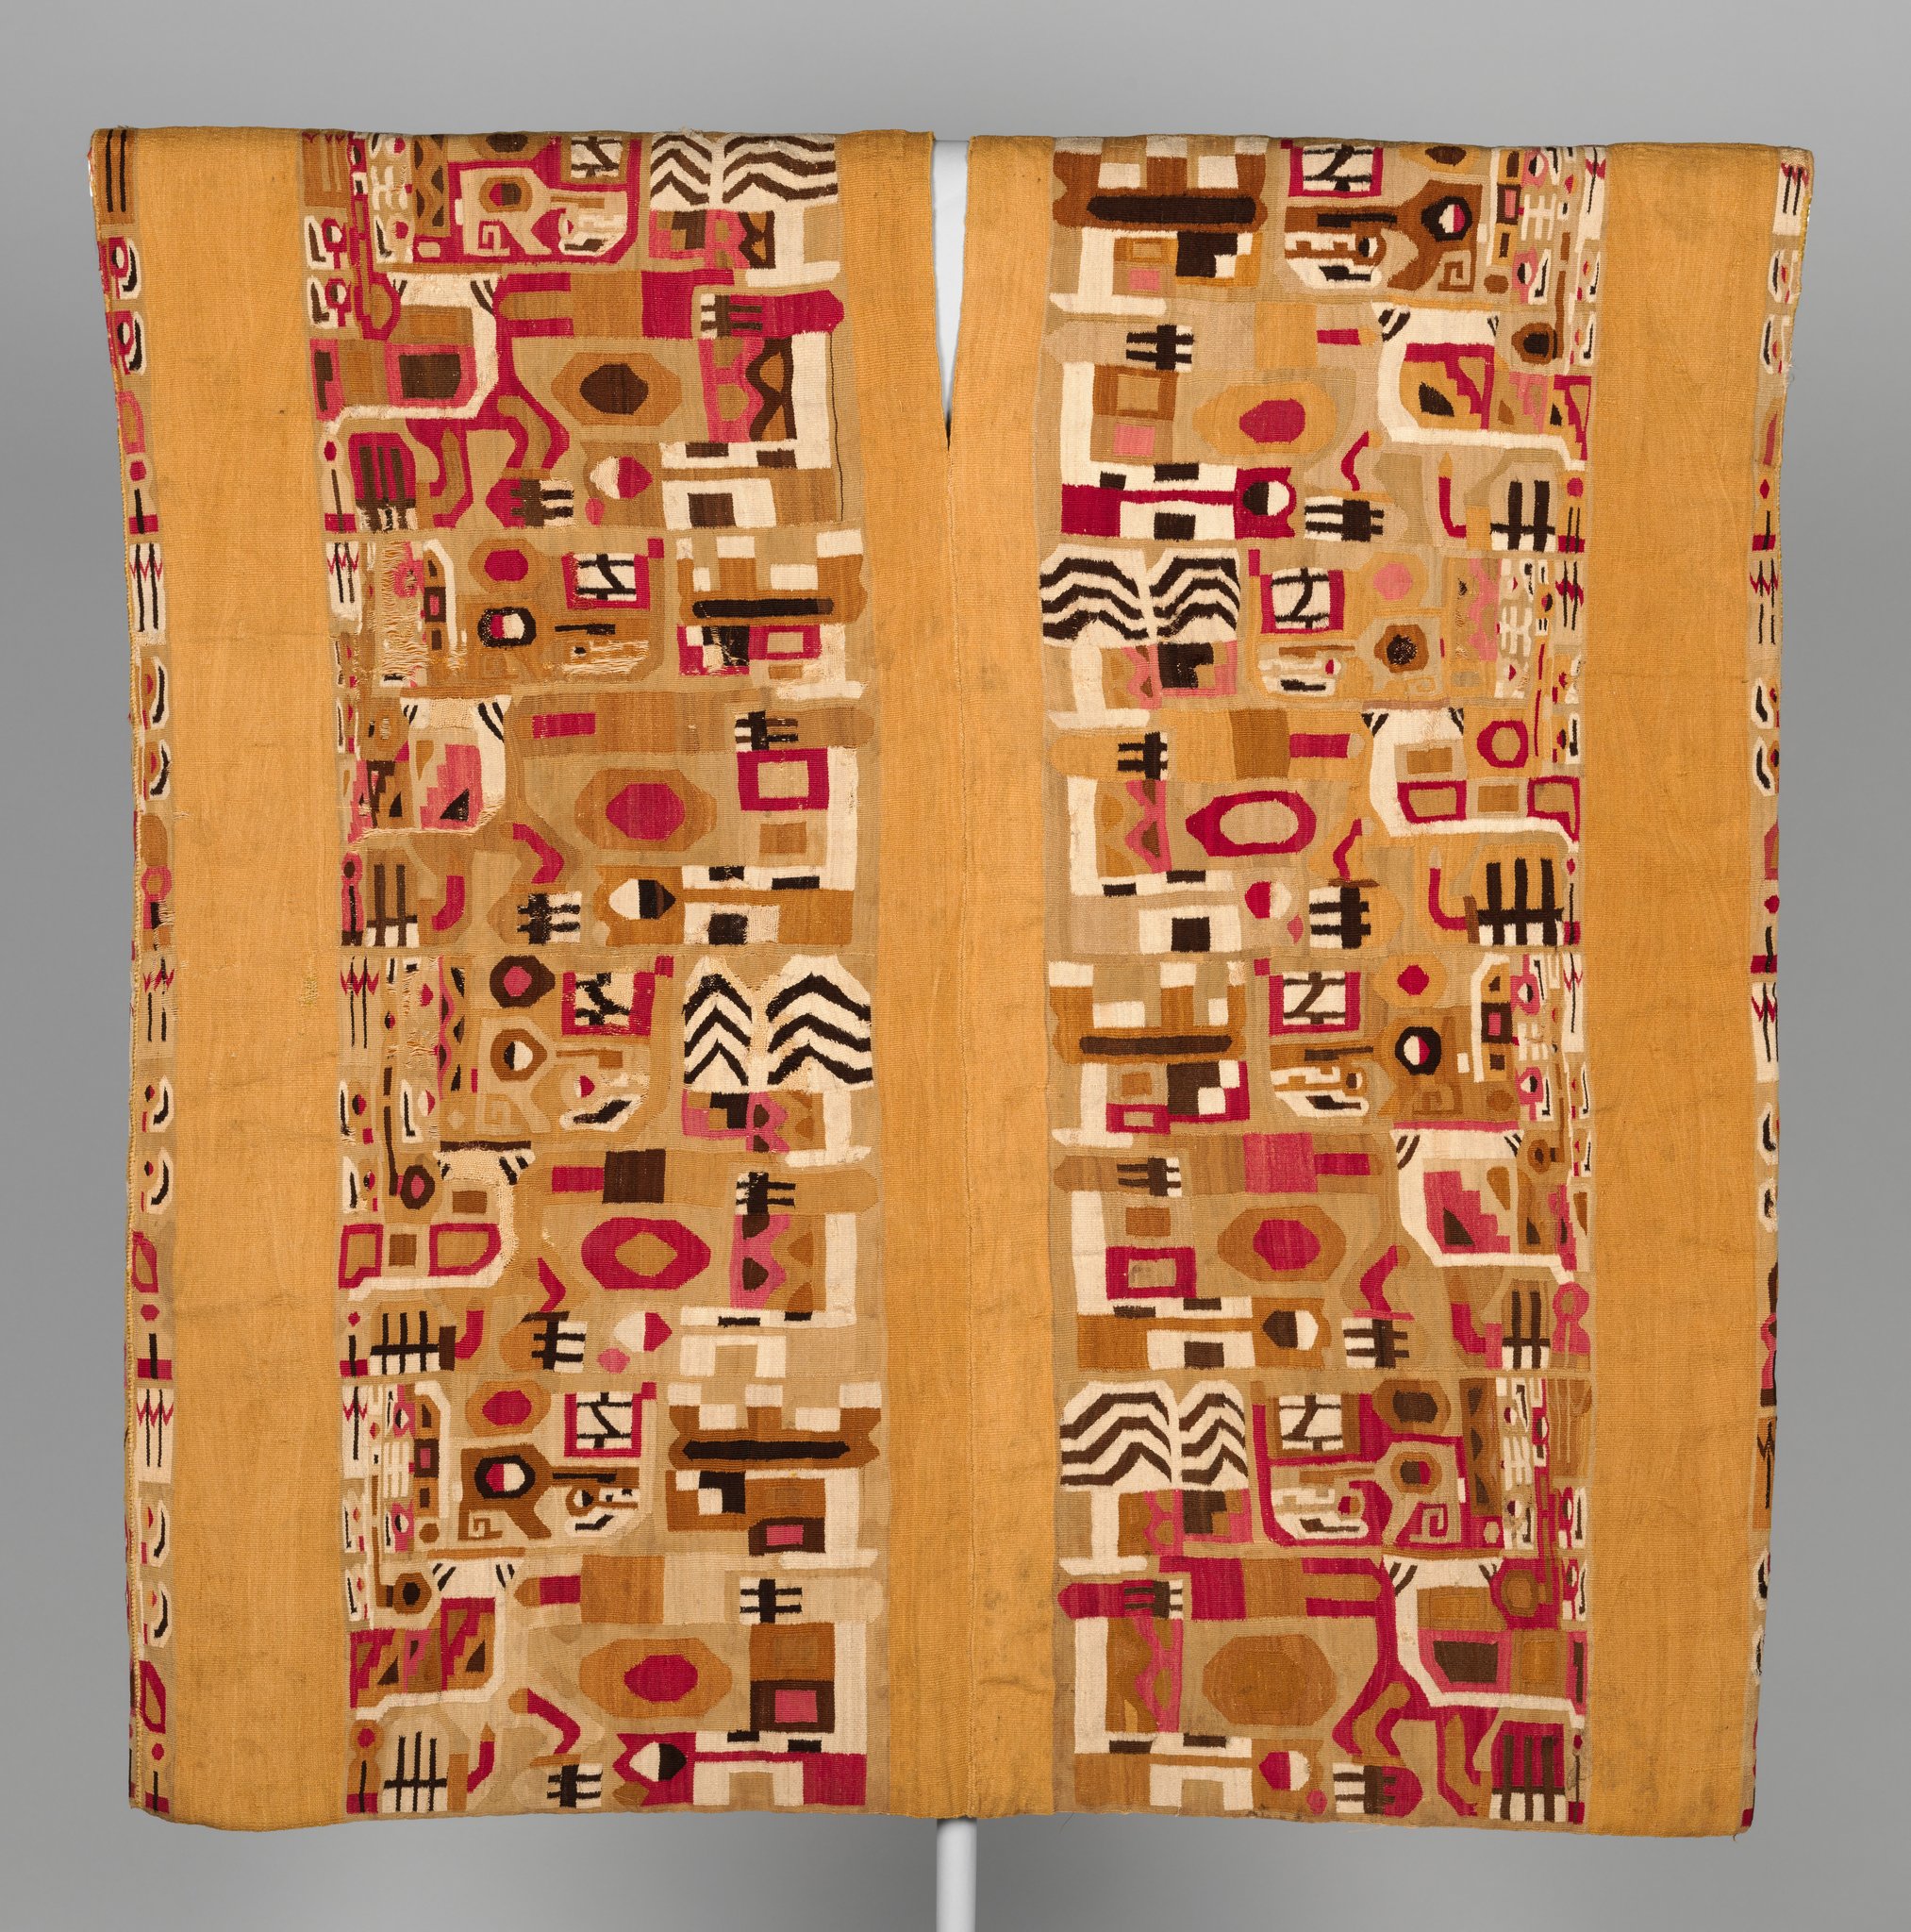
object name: tunic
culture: wari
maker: wari artist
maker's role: artist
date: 650-1000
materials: animal fiber, cotton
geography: andean region